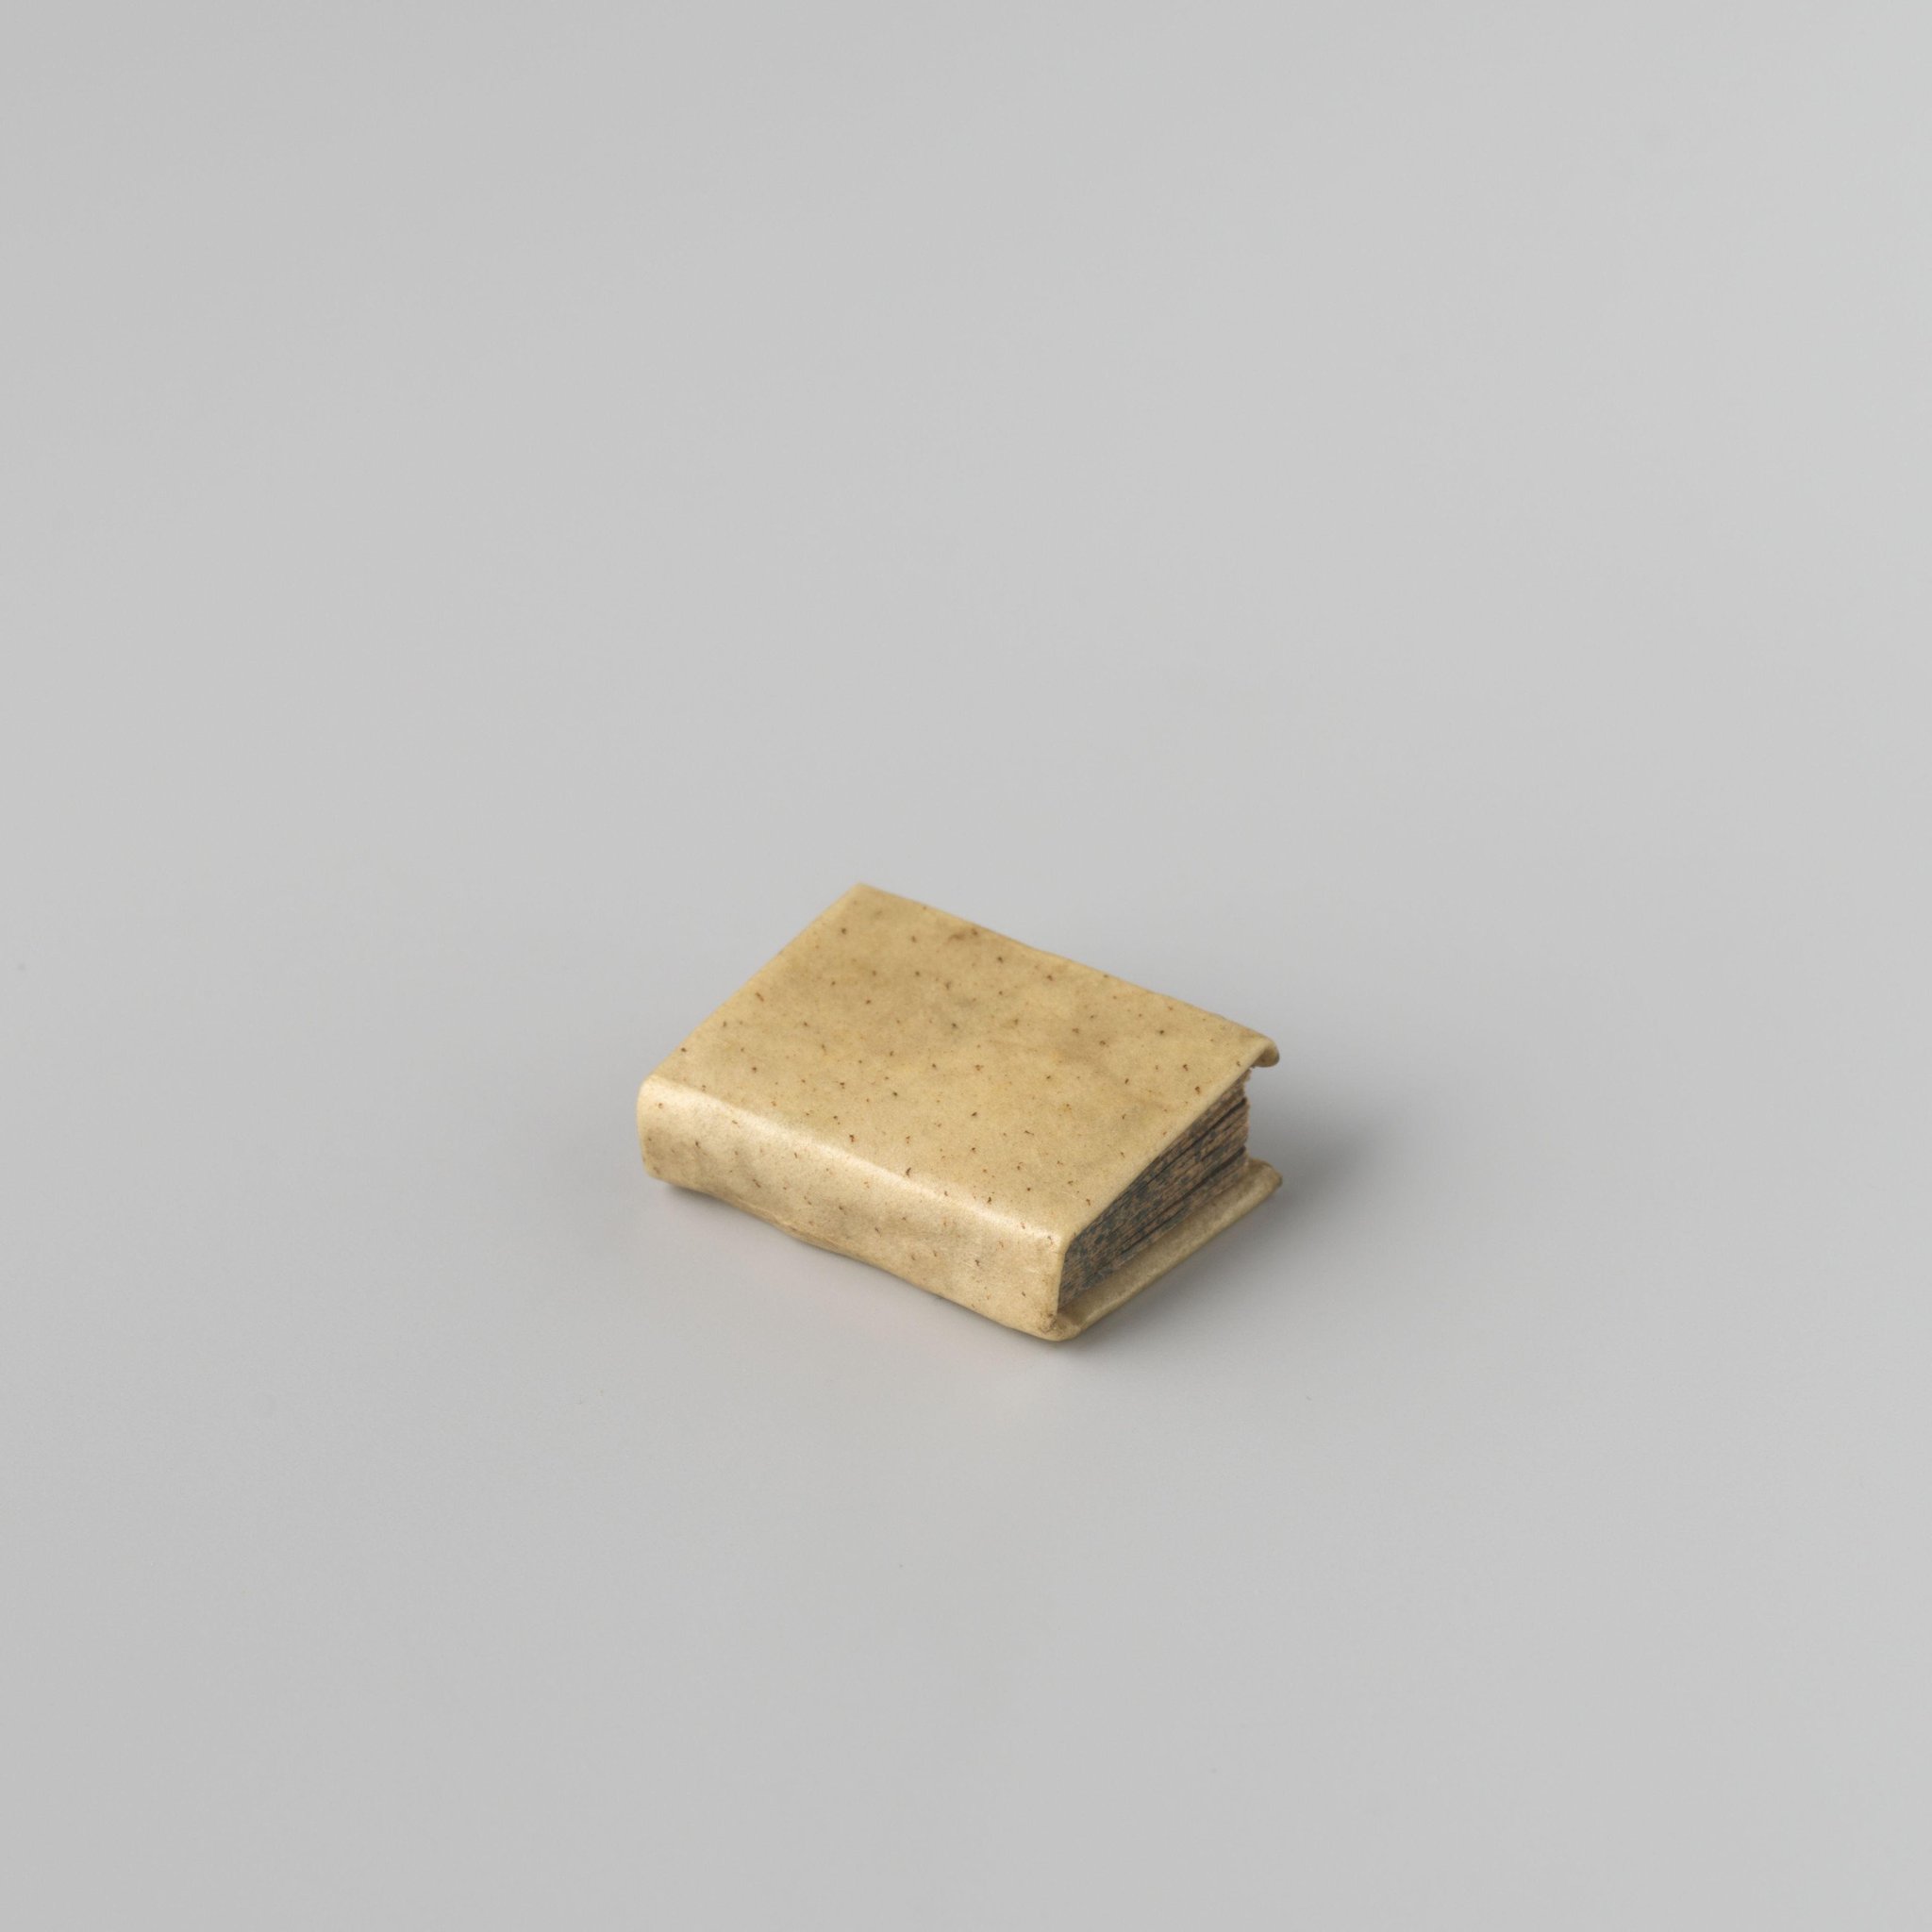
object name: miniature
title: Boek met figuren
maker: Anonymous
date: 1690-1710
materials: paper, parchment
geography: amsterdam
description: Boek met figuren. Ingebonden in blank perkament.